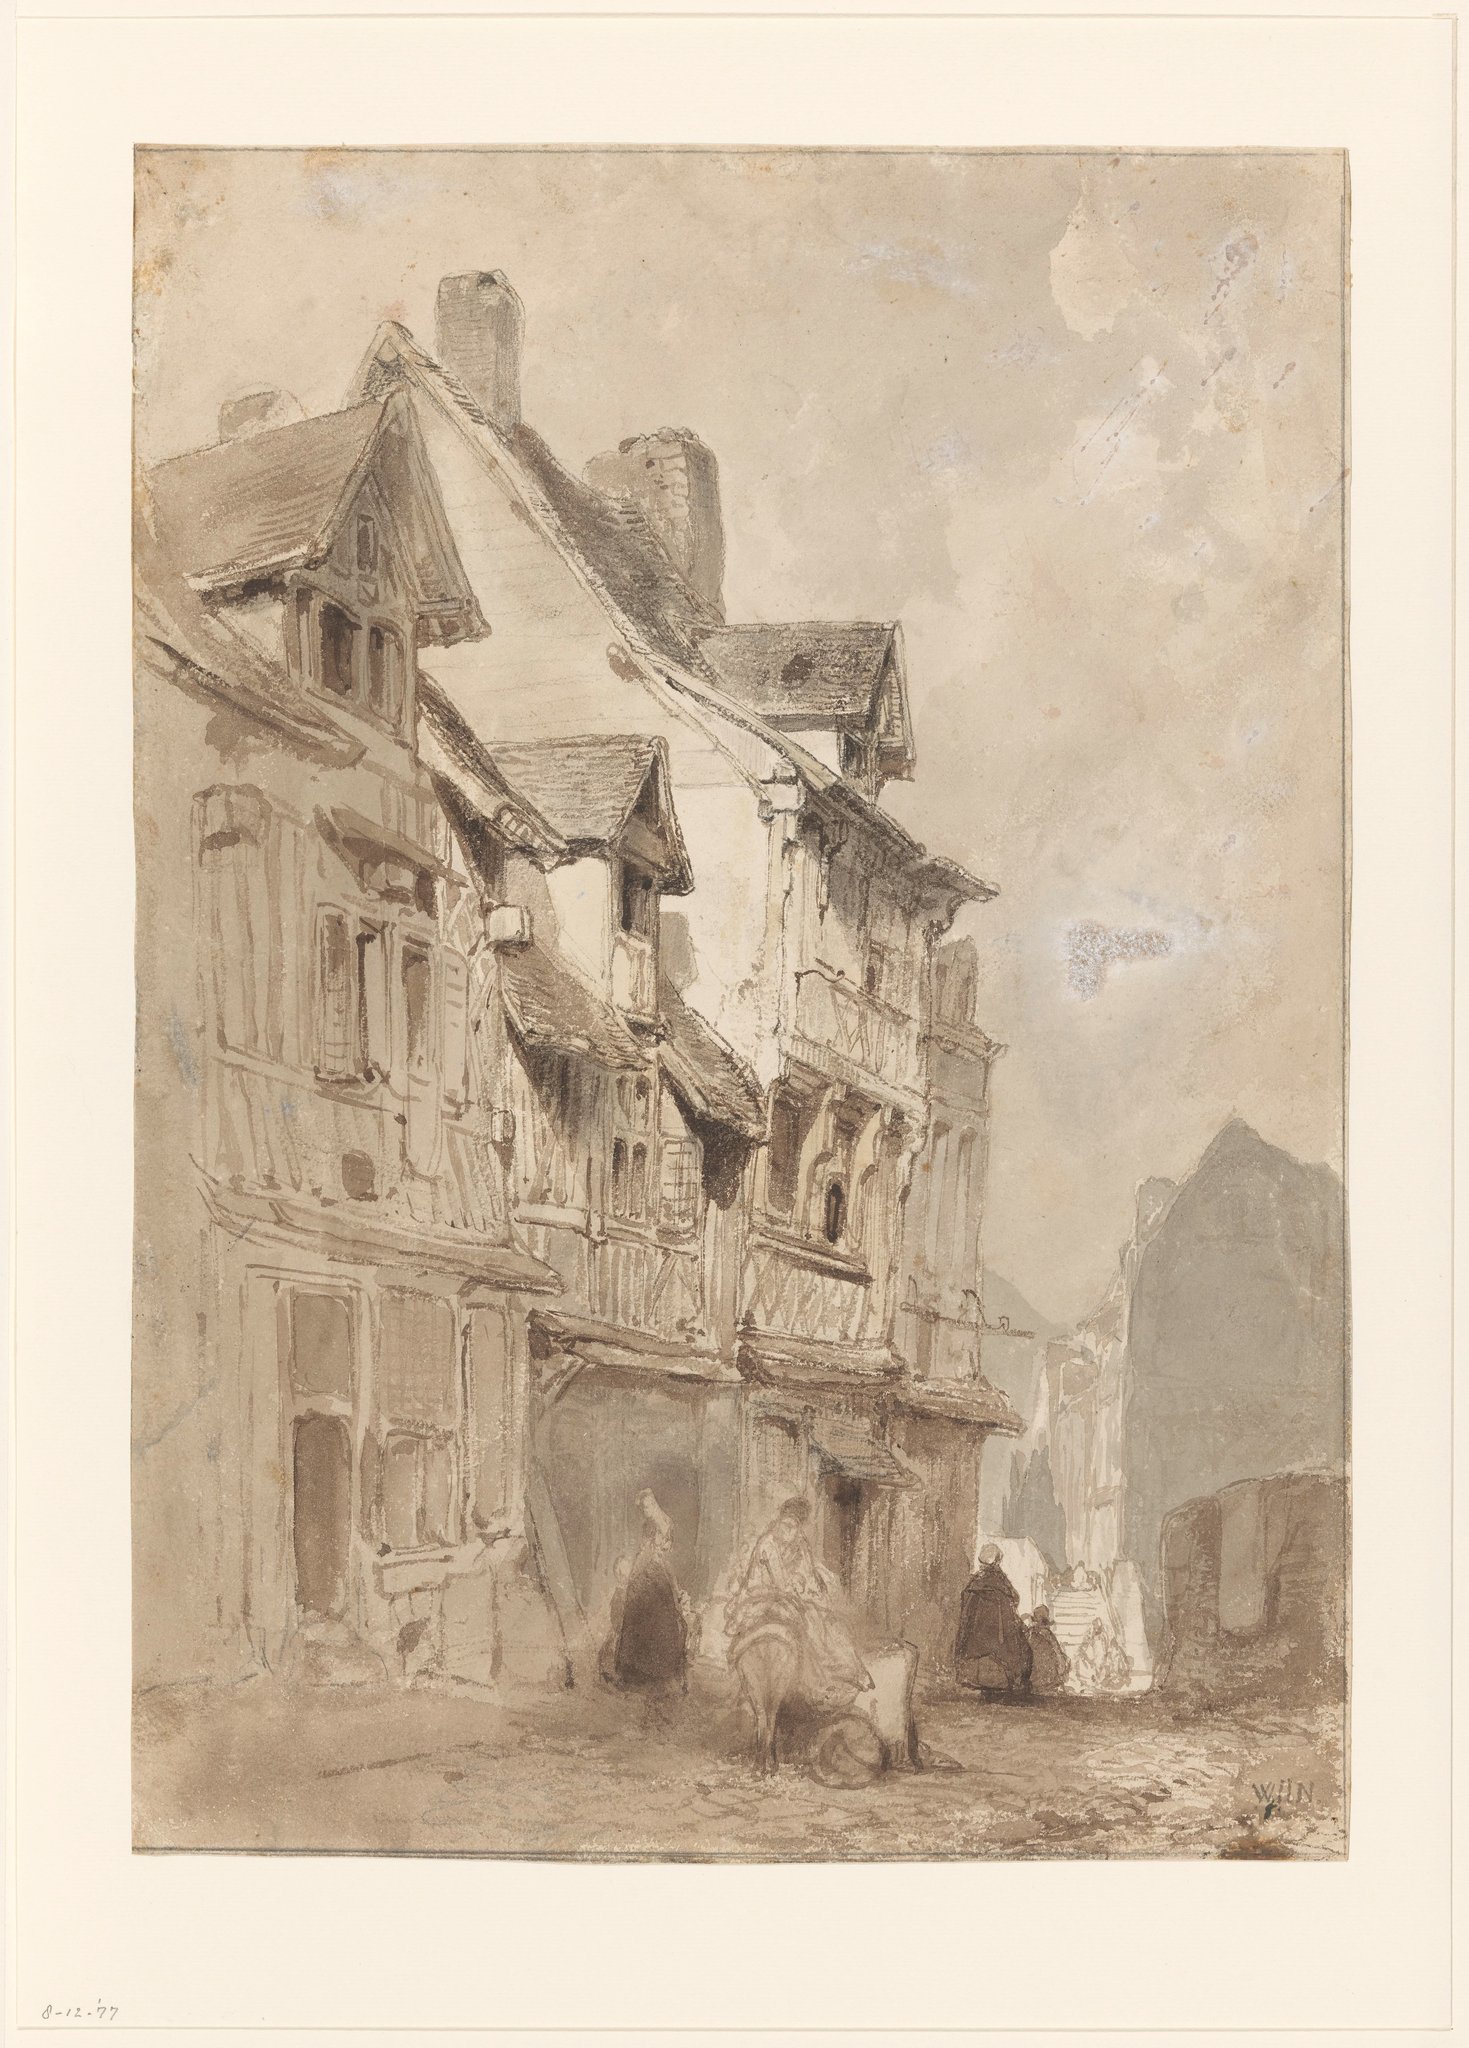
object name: drawing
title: Straat in een Duitse stad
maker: wijnand nuijen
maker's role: draughtsman, painter, print maker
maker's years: 1813-1839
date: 1823-1839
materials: paper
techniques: brush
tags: street, germany